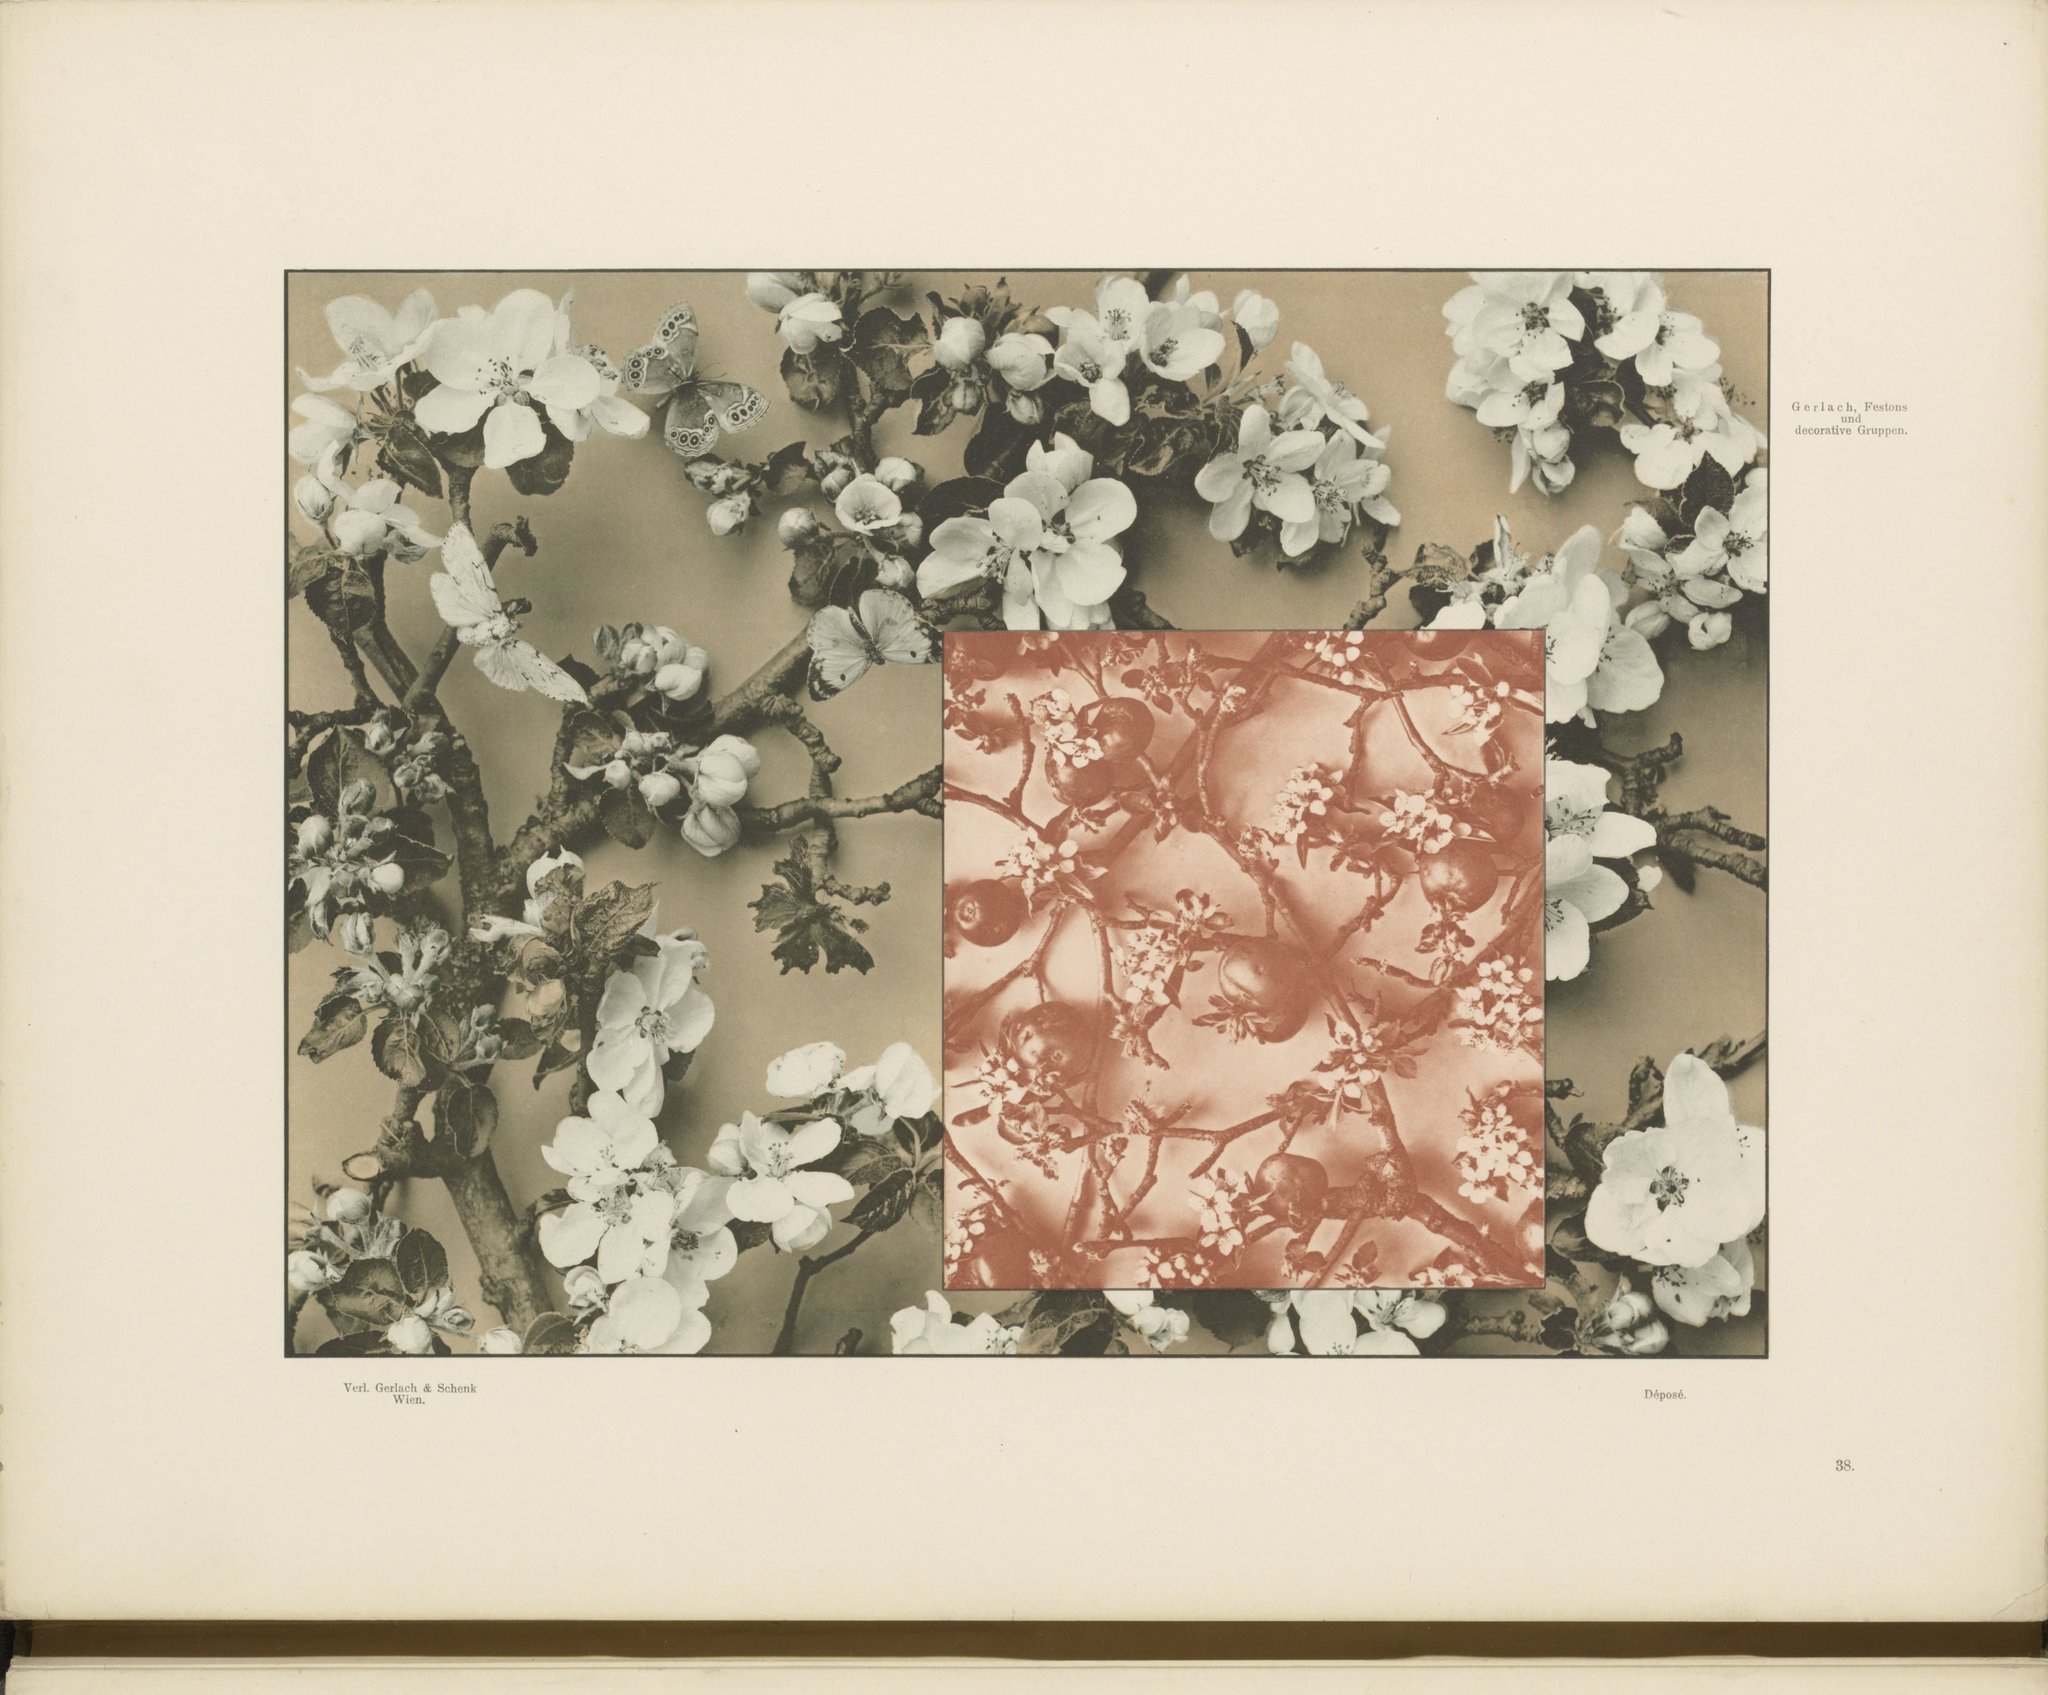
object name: page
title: Decoratieve groep met appelbloesem en vlinders en een vlakvulling met appelbloesem en appels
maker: Anonymous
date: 1887-1897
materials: paper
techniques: photograph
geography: vienna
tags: fruits: apple (flowers, blossom, blossoming), insects: butterfly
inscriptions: number: ‘38.’